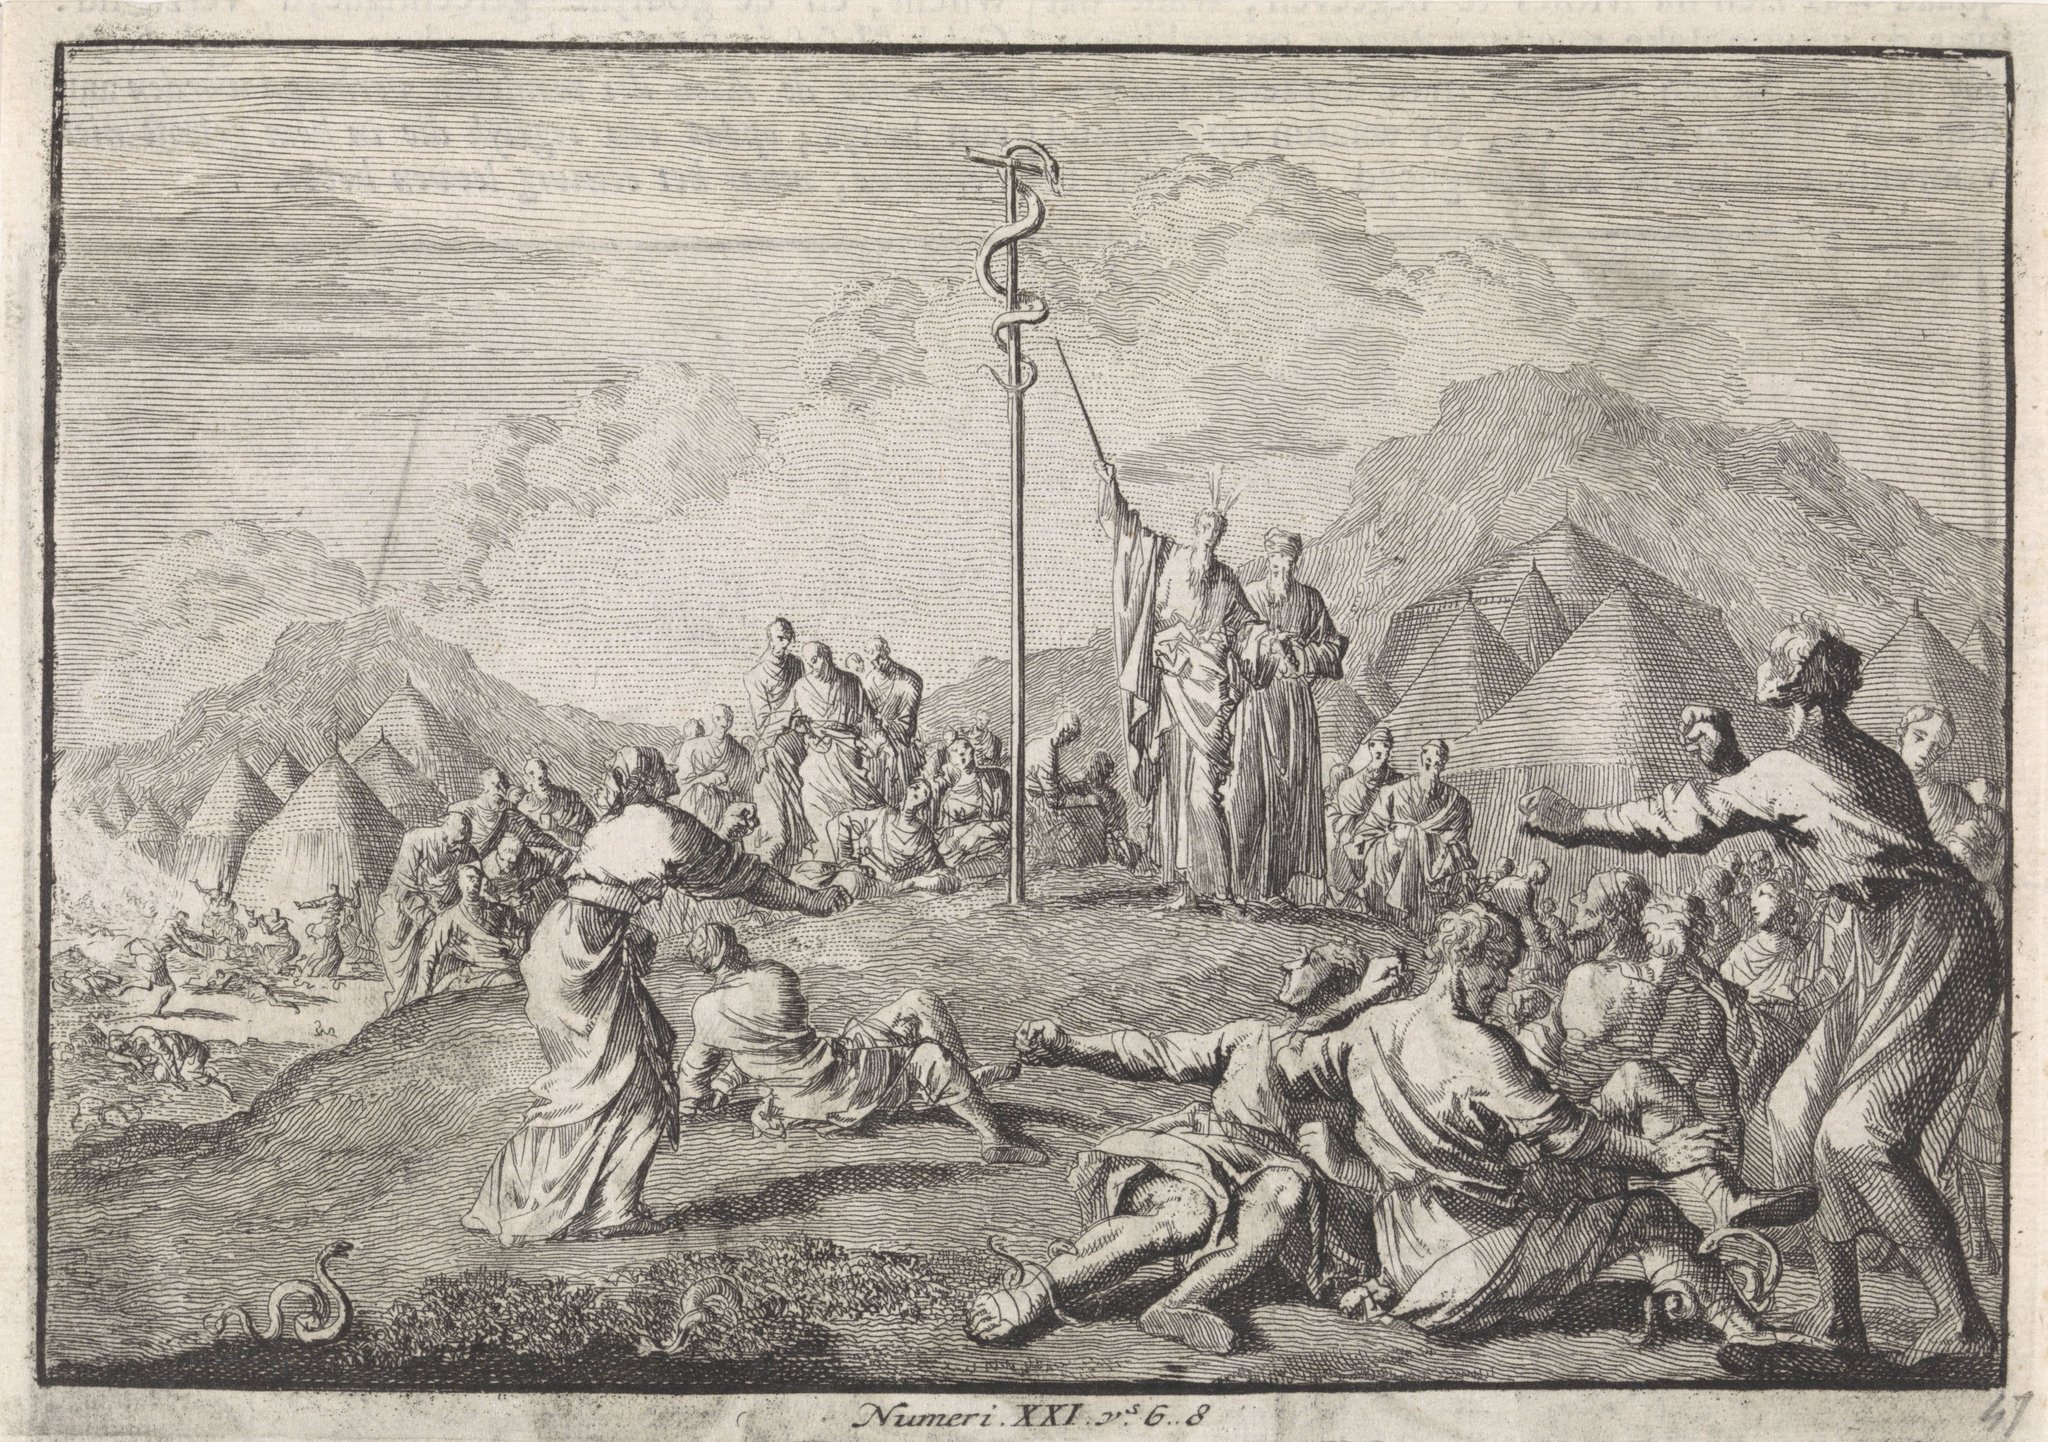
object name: print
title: Oprichting van de koperen slang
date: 1703-1762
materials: paper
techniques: etching, letterpress printing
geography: amsterdam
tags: the brazen serpent (numbers 21:4-9)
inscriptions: collector's mark: Lugt 2228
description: De prent komt een eerste keer voor als boekillustratie voor David Martin. Historie des Ouden en Nieuwen Testaments. Amsterdam, Pieter Mortier, 1703. Deel I. De boekillustraties voor de Mortierbijbel hebben verschillende staten en kopieën, waarbij de chronologische volgorde moeilijk te achterhalen valt. Als boekillustraties werden ze bovendien herhaaldelijk opnieuw gebruikt voor andere boekwerken.